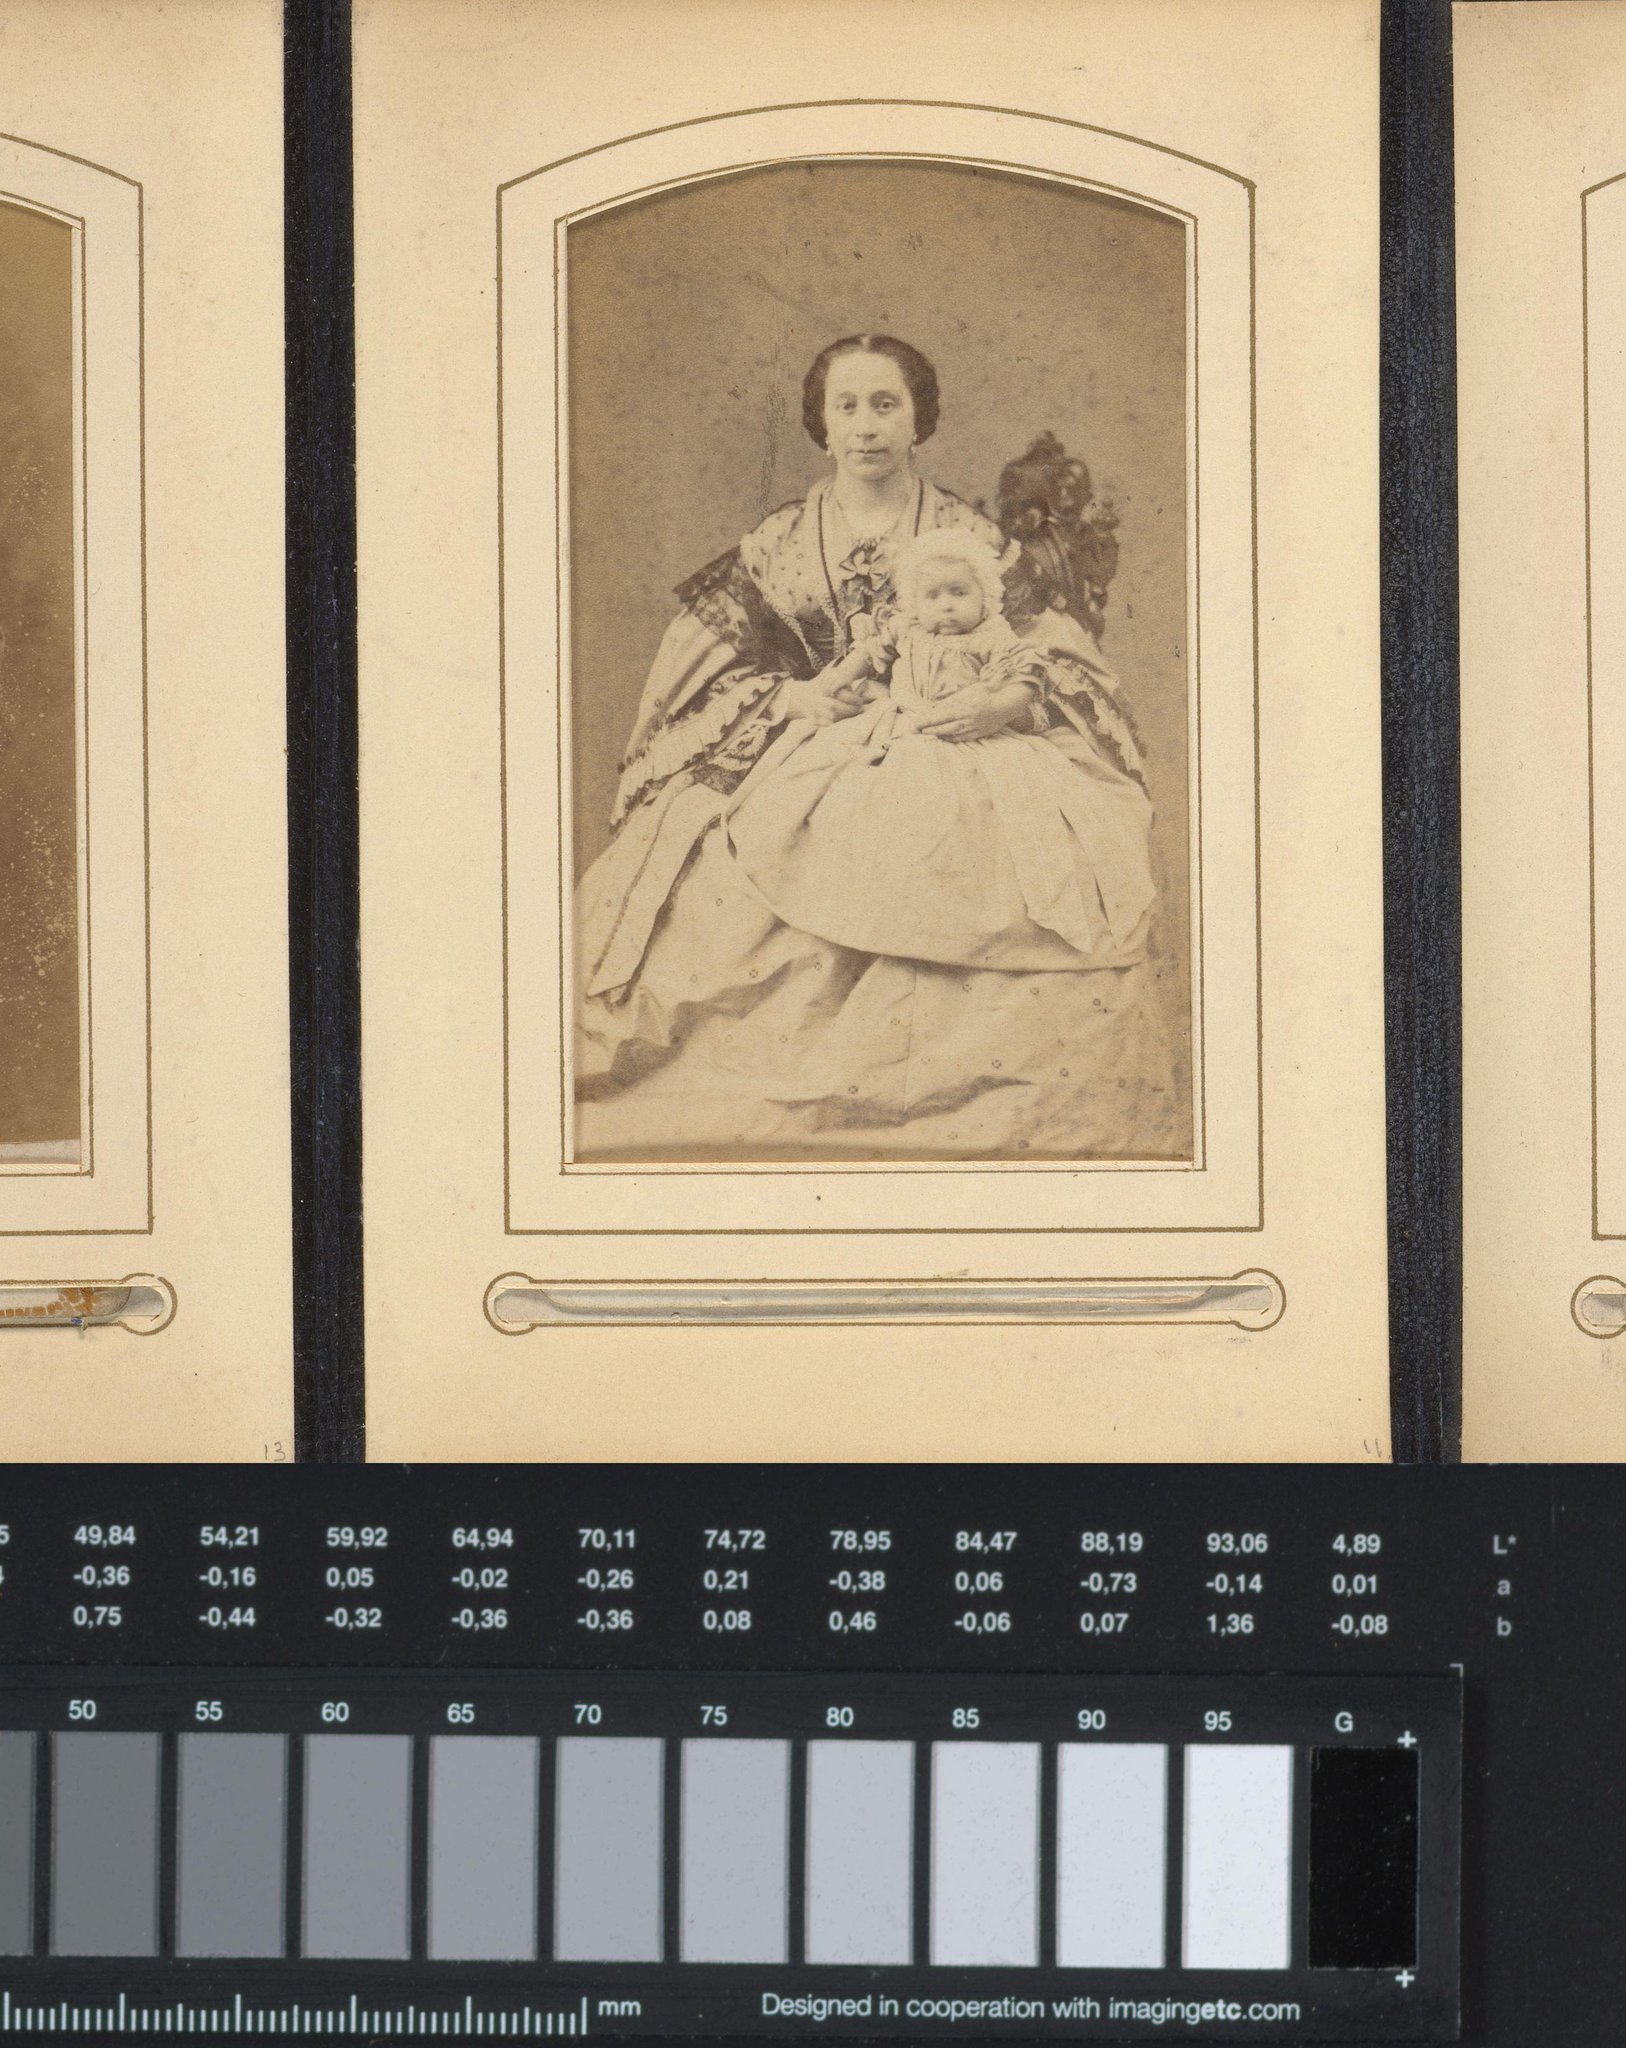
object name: photograph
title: Portret van een zittende vrouw met baby op schoot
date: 1857-1864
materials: cardboard, photographic support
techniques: albumen print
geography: rotterdam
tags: sitting figure - aa - female human figure, historical persons - bb - woman, infant, baby ~ the ages of man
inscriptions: inscription: ‘CARO & van LOO/ ROTTERDAM/ Weenaplein.’